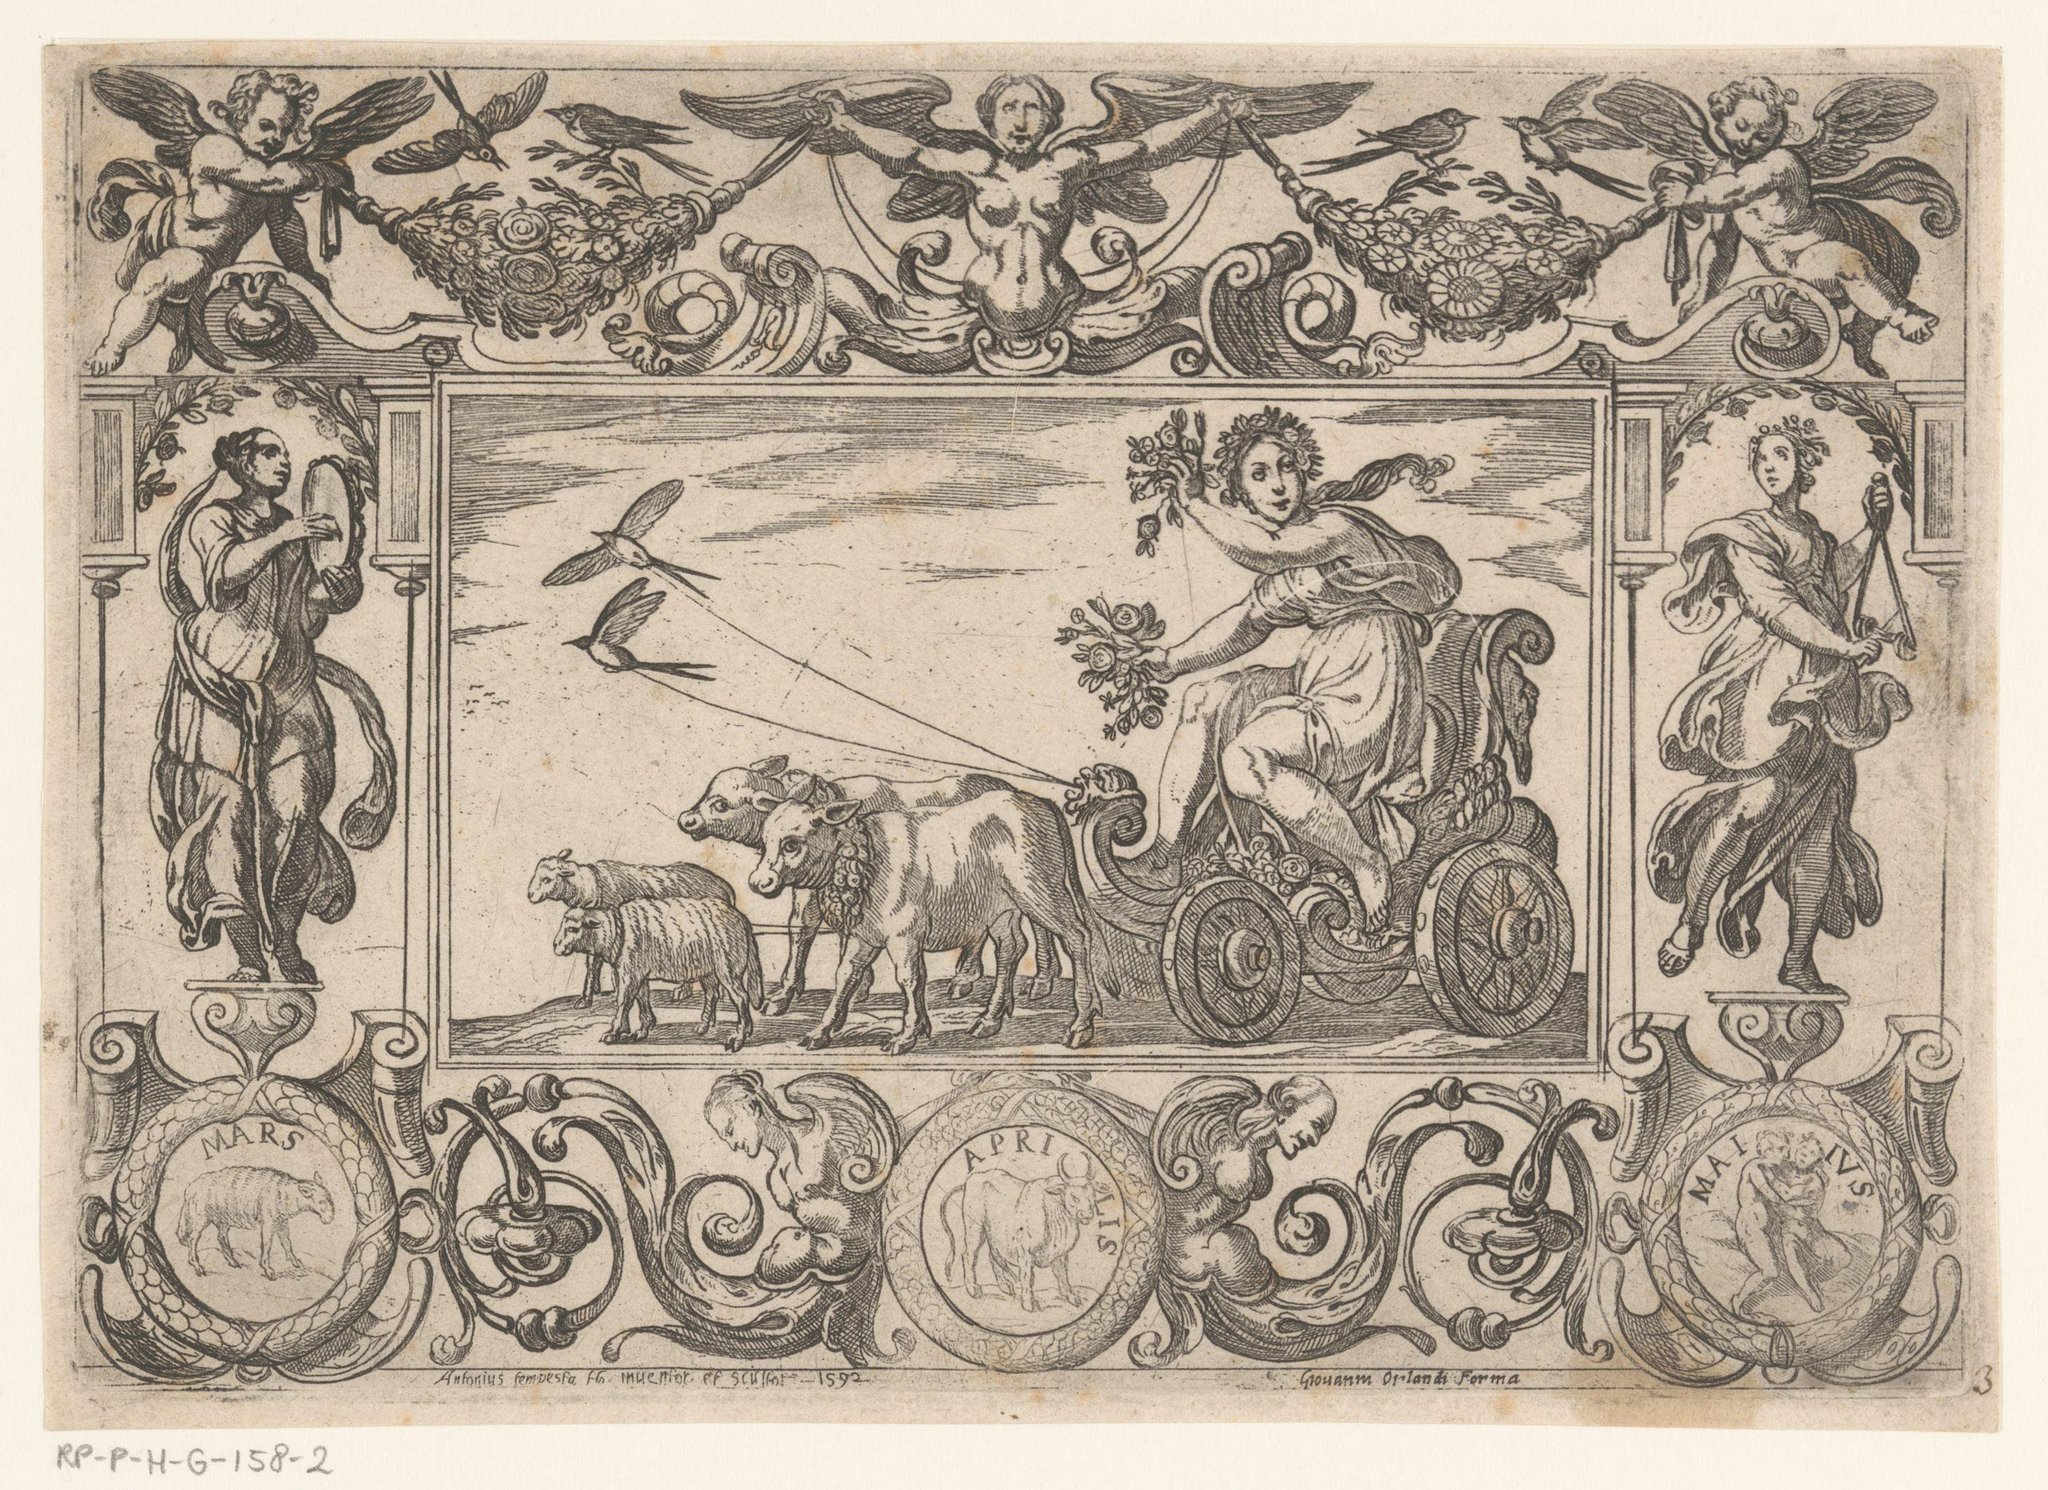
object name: print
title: Lente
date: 1592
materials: paper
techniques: etching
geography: rome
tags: summer, 'aestas'; 'estate' (ripa)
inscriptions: number: ‘3’, collector's mark: ‘Hinloopen’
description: Een vrouw met bloemen in haar handen op een wagen die wordt voortgetrokken door twee kalveren, twee lammetjes en twee zwaluwen. De voorstelling wordt omgeven door een ornamentele sierrand met medaillons met de maanden, vrouwen met muziekinstrumenten en gevleugelde figuren.